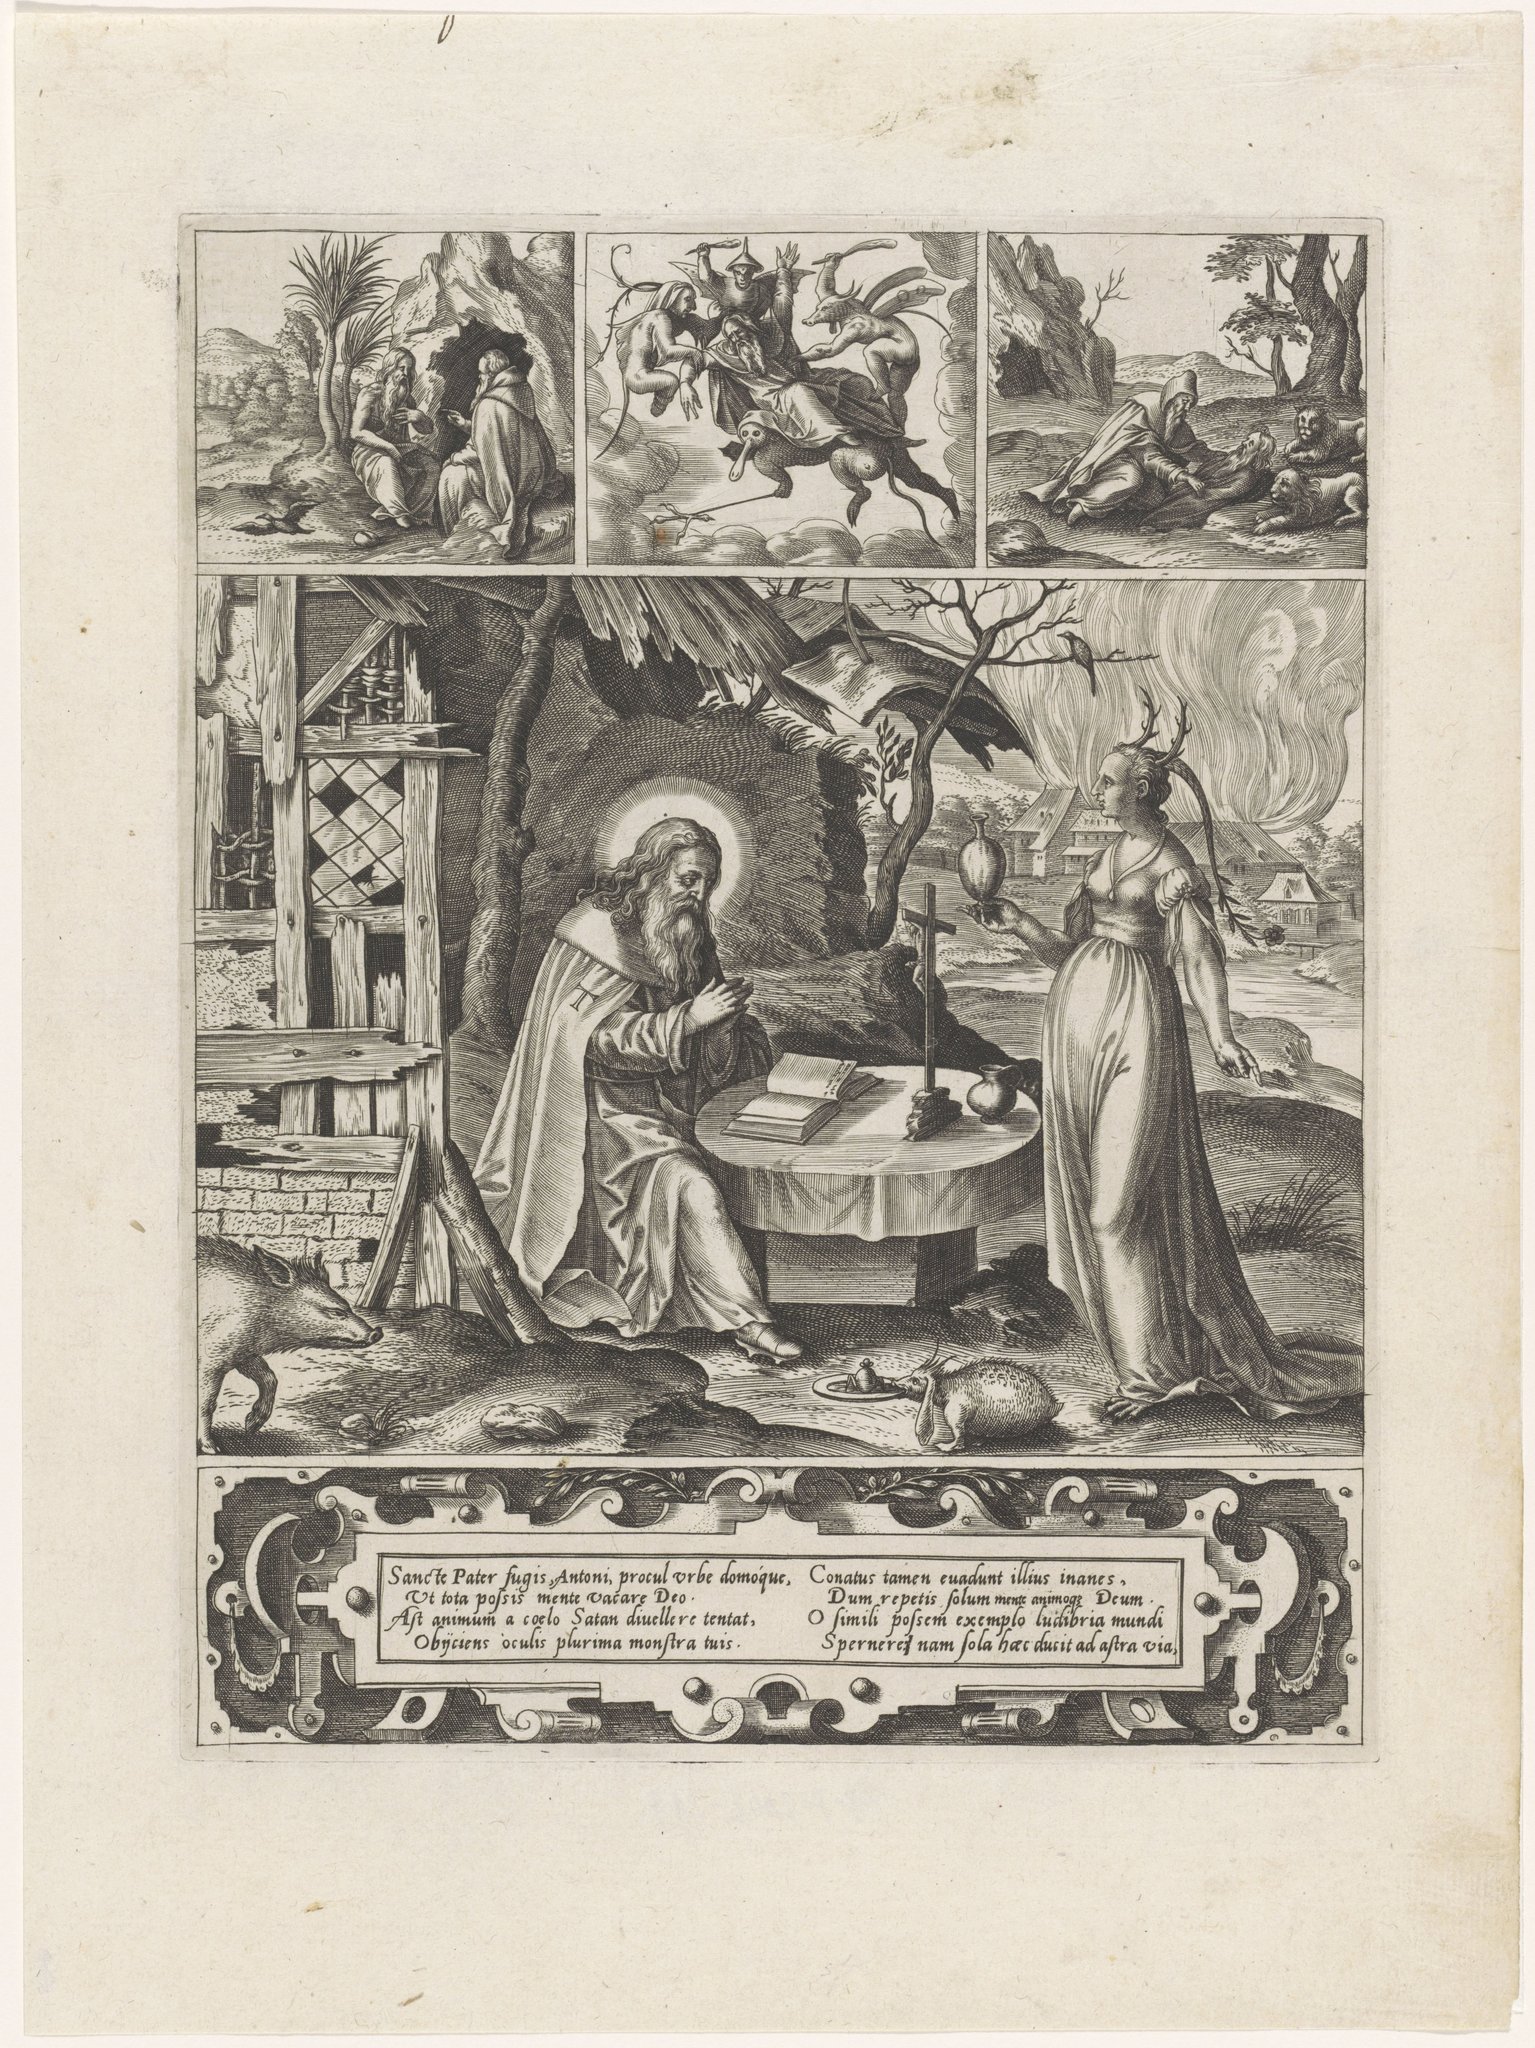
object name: print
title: Verzoeking van de H. Antonius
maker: pieter huys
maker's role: draughtsman, painter, print maker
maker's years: 1509-1591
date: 1560-1580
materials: paper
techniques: engraving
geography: antwerp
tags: st. antony abbot tormented by devils, attacking him on the ground or carrying him aloft, the erotic visions of st. antony abbot: he is tempted by (naked) women, but drives them off by praying, or by showing them a crucifix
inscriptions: collector's mark: Lugt 2228, collector's mark: Lugt 2760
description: De H. Antonius zit geknield voor een hut, aan een ronde tafel waarop een open boek en crucifix. Voor hem verschijnt een vrouw met hertengewei en slangenstaart op het hoofd, een kruik in de hand. Links het zwijn. Op de achtergrond een brandende stad. Bovenaan in drie kaders drie scènes uit zijn leven. Onderaan een onderschrift in het Latijn in een cartouche.